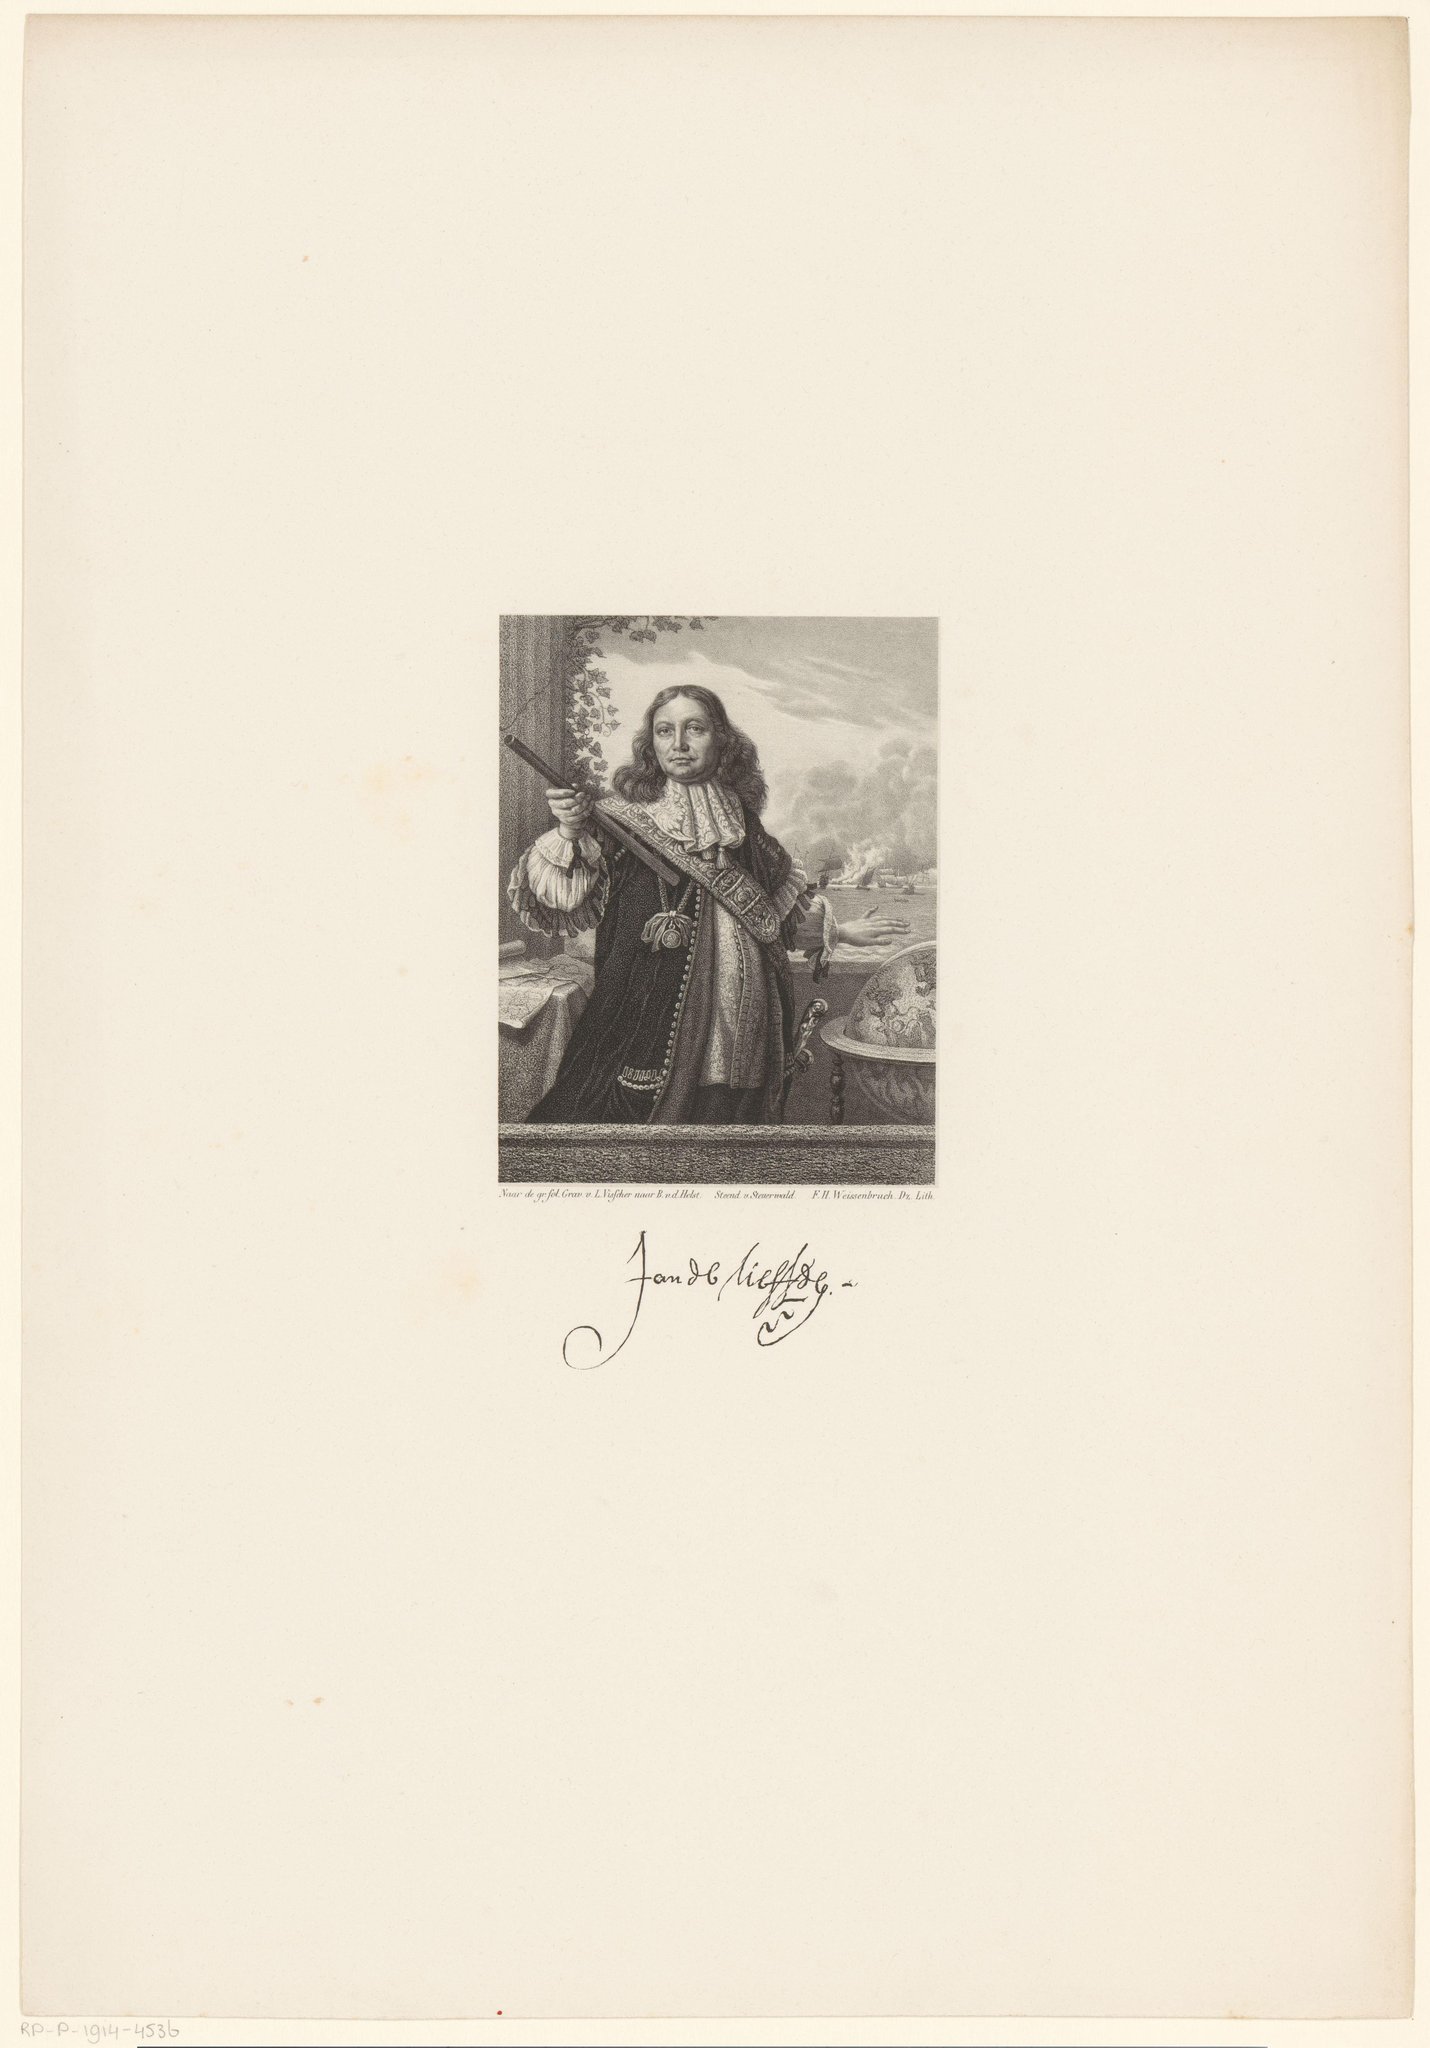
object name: print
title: Portret van Johan de Liefde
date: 1858-1862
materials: paper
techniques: lithograph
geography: the hague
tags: johan de liefde, historical persons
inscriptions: collector's mark: Lugt 2228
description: Prent uit: Jonge, J.C. de. Geschiedenis van het Nederlandsche zeewezen. Haarlem: Jonge, J.K.J. de, 1858-62.